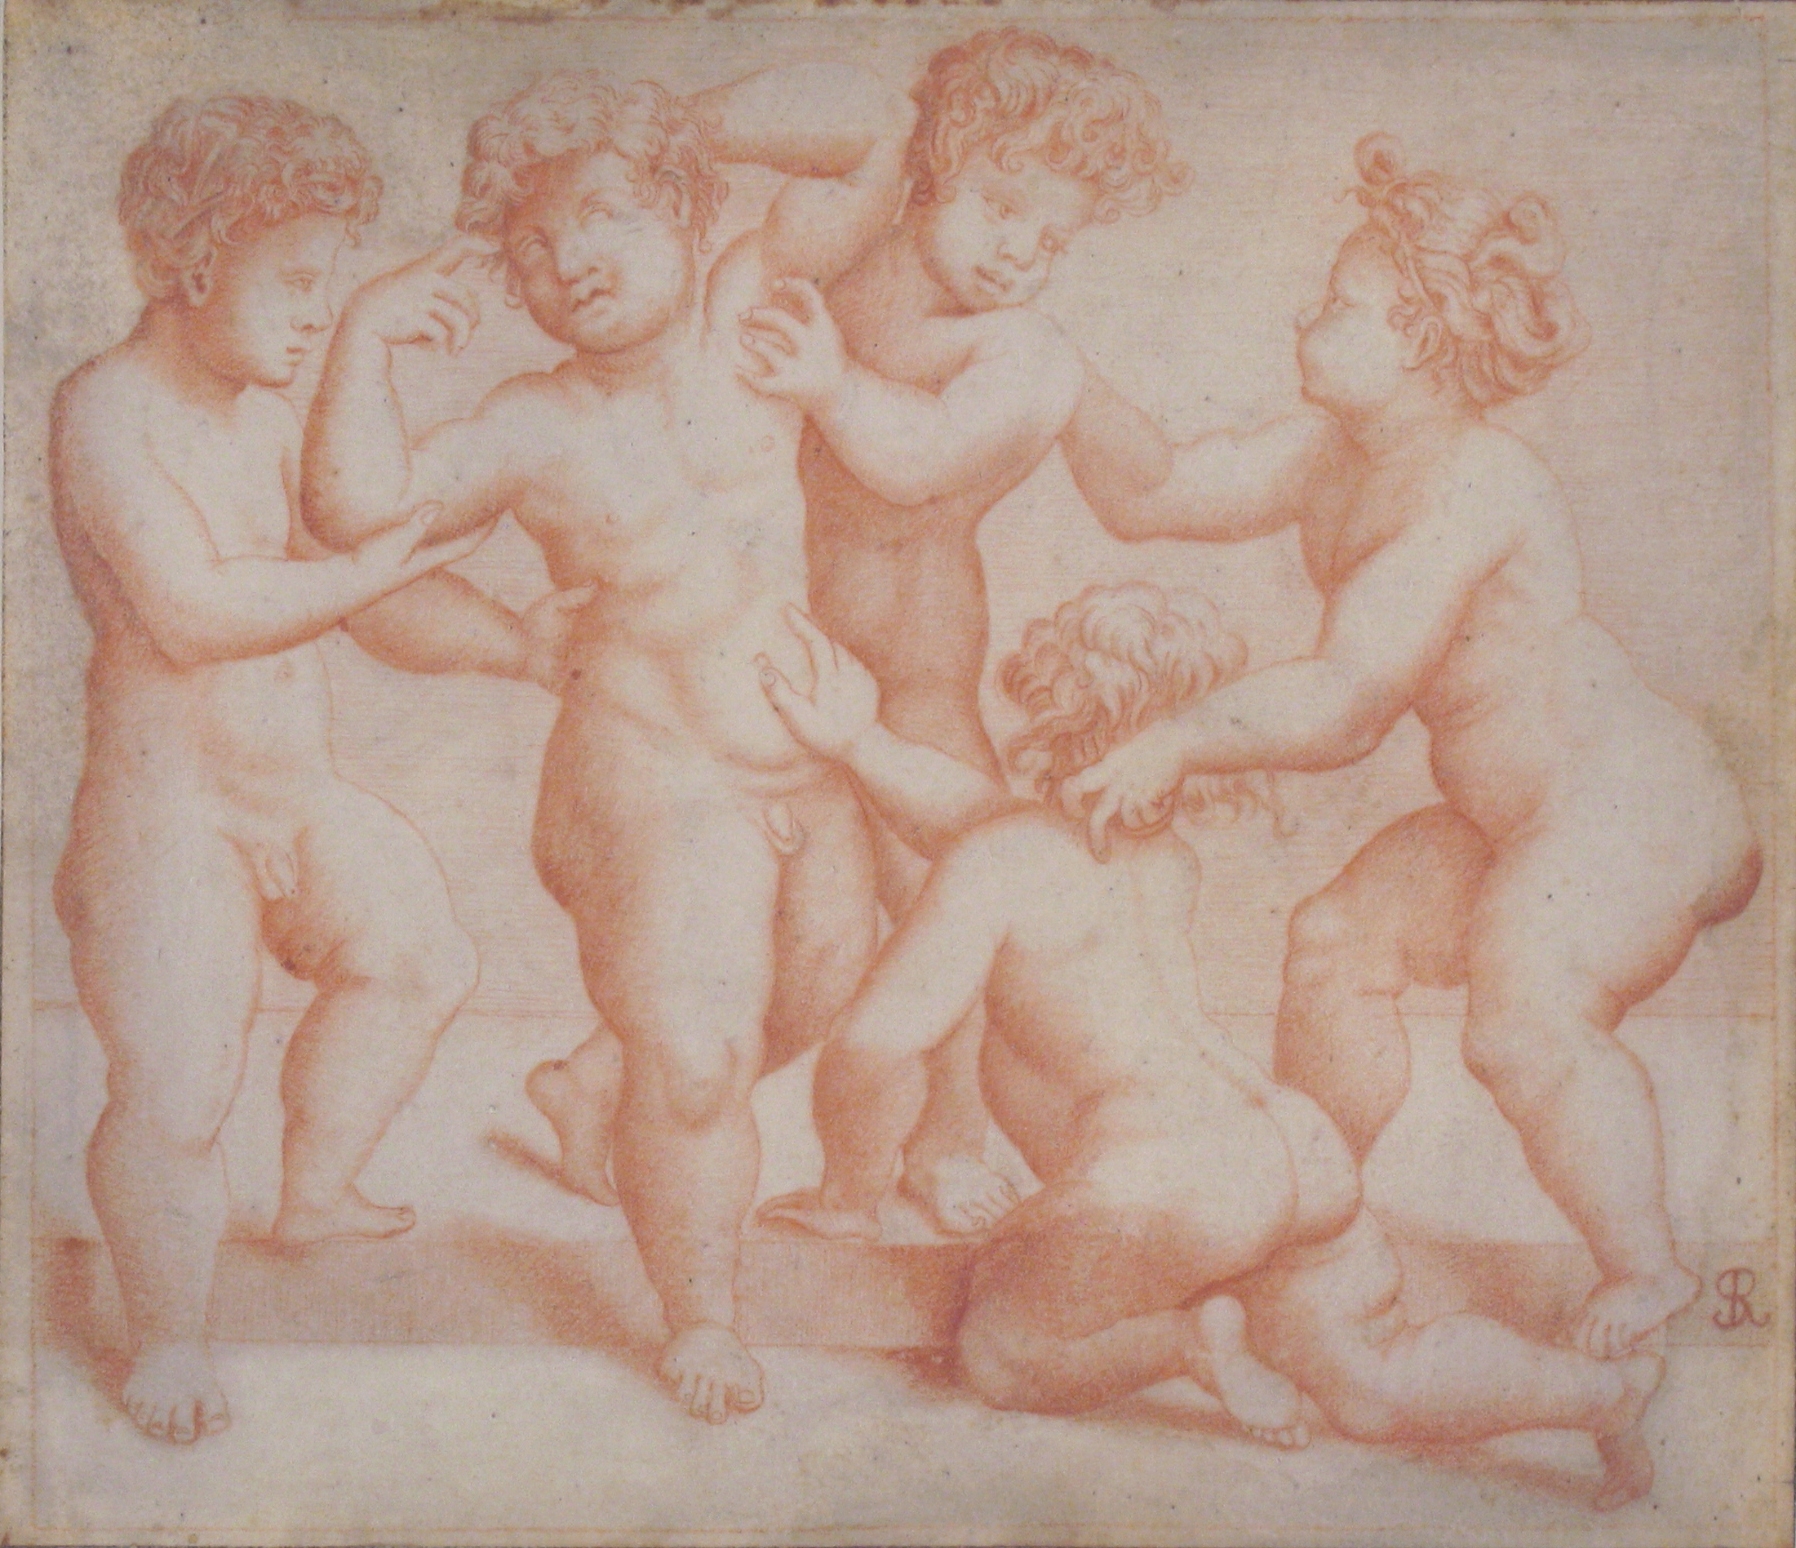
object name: drawing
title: Frieze of Five Putti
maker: marco dente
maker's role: artist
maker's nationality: italian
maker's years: 1515-1527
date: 1515-1527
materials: chalk, parchment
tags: boys